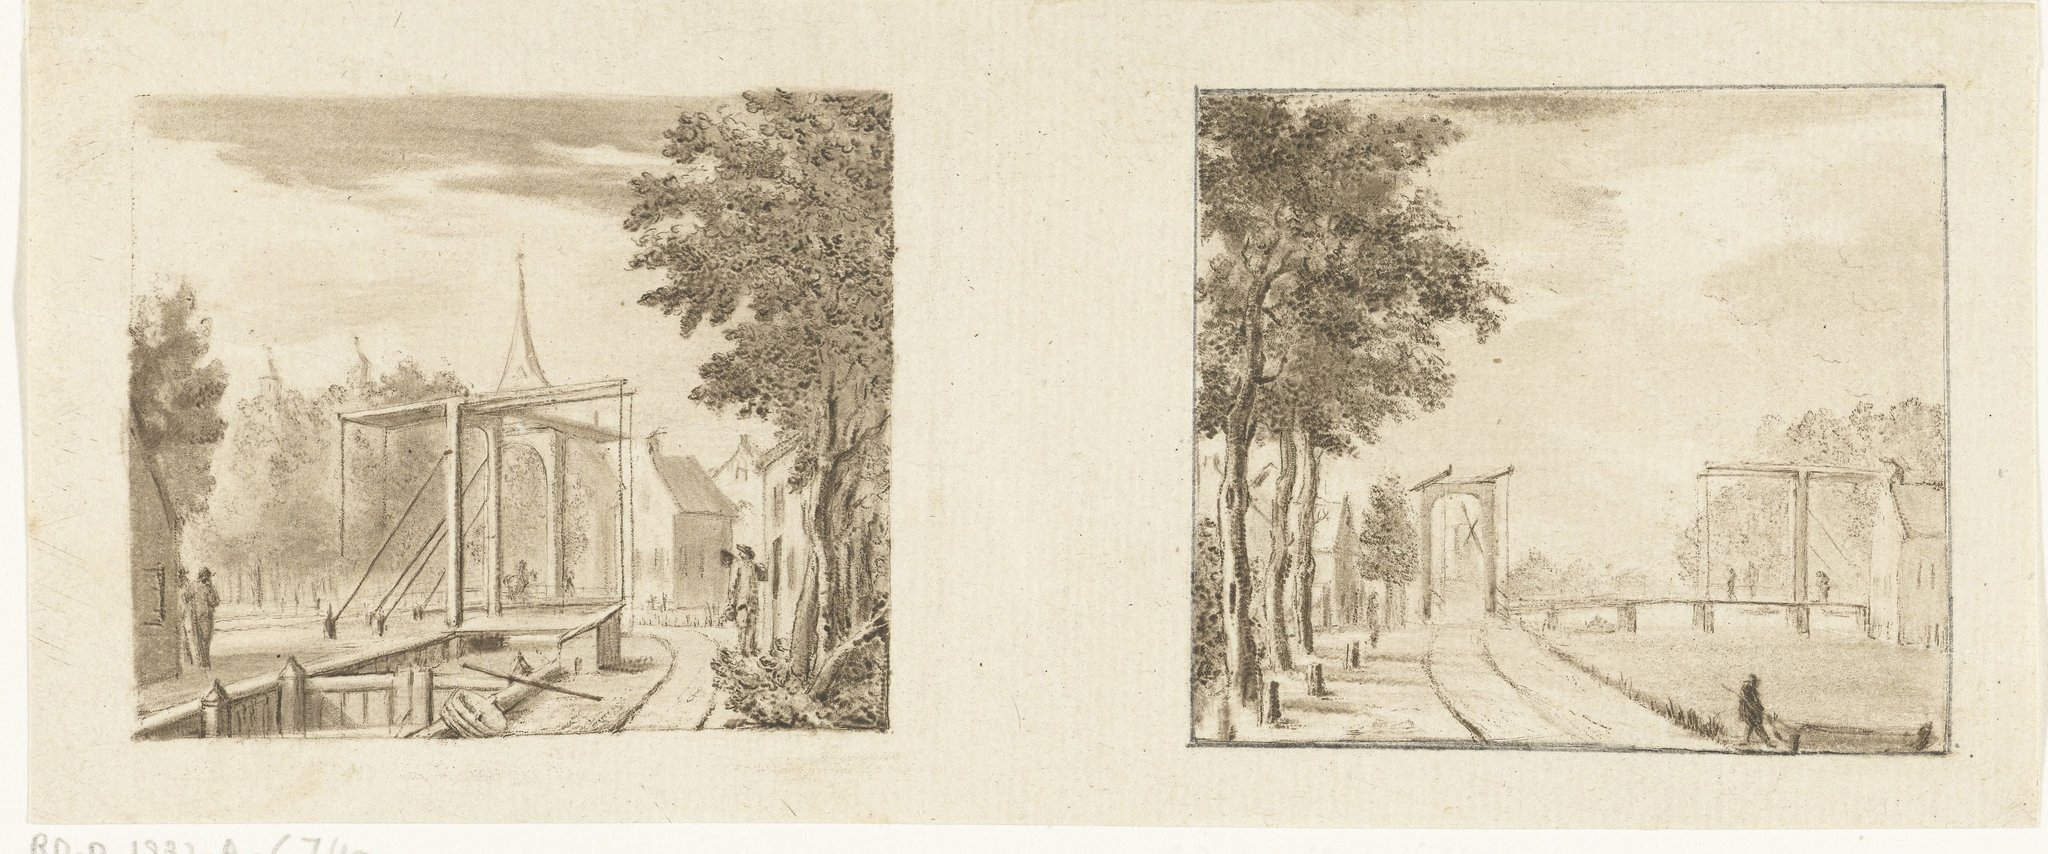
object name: print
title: Gezicht op Nederhorst ten Berg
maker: jurriaan cootwijck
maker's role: print maker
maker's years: 1714-1798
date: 1744-1798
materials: paper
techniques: print drawing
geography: amsterdam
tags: landscape with bridge, viaduct or aqueduct (+ city(-scape) with figures, staffage), sluice, weir (+ landscape with figures, staffage), boat propelled by man or animal, nederhorst den berg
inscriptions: collector's mark: Lugt 2228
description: Gezicht op Nederhorst ten Berg. Linkerprent: op de voorgrond het kanaal en de sluis. Op de achtergrond de kerktoren. Rechterprent: op de voorgrond het kanaal. Op de achtergrond de brug. Links een weg.